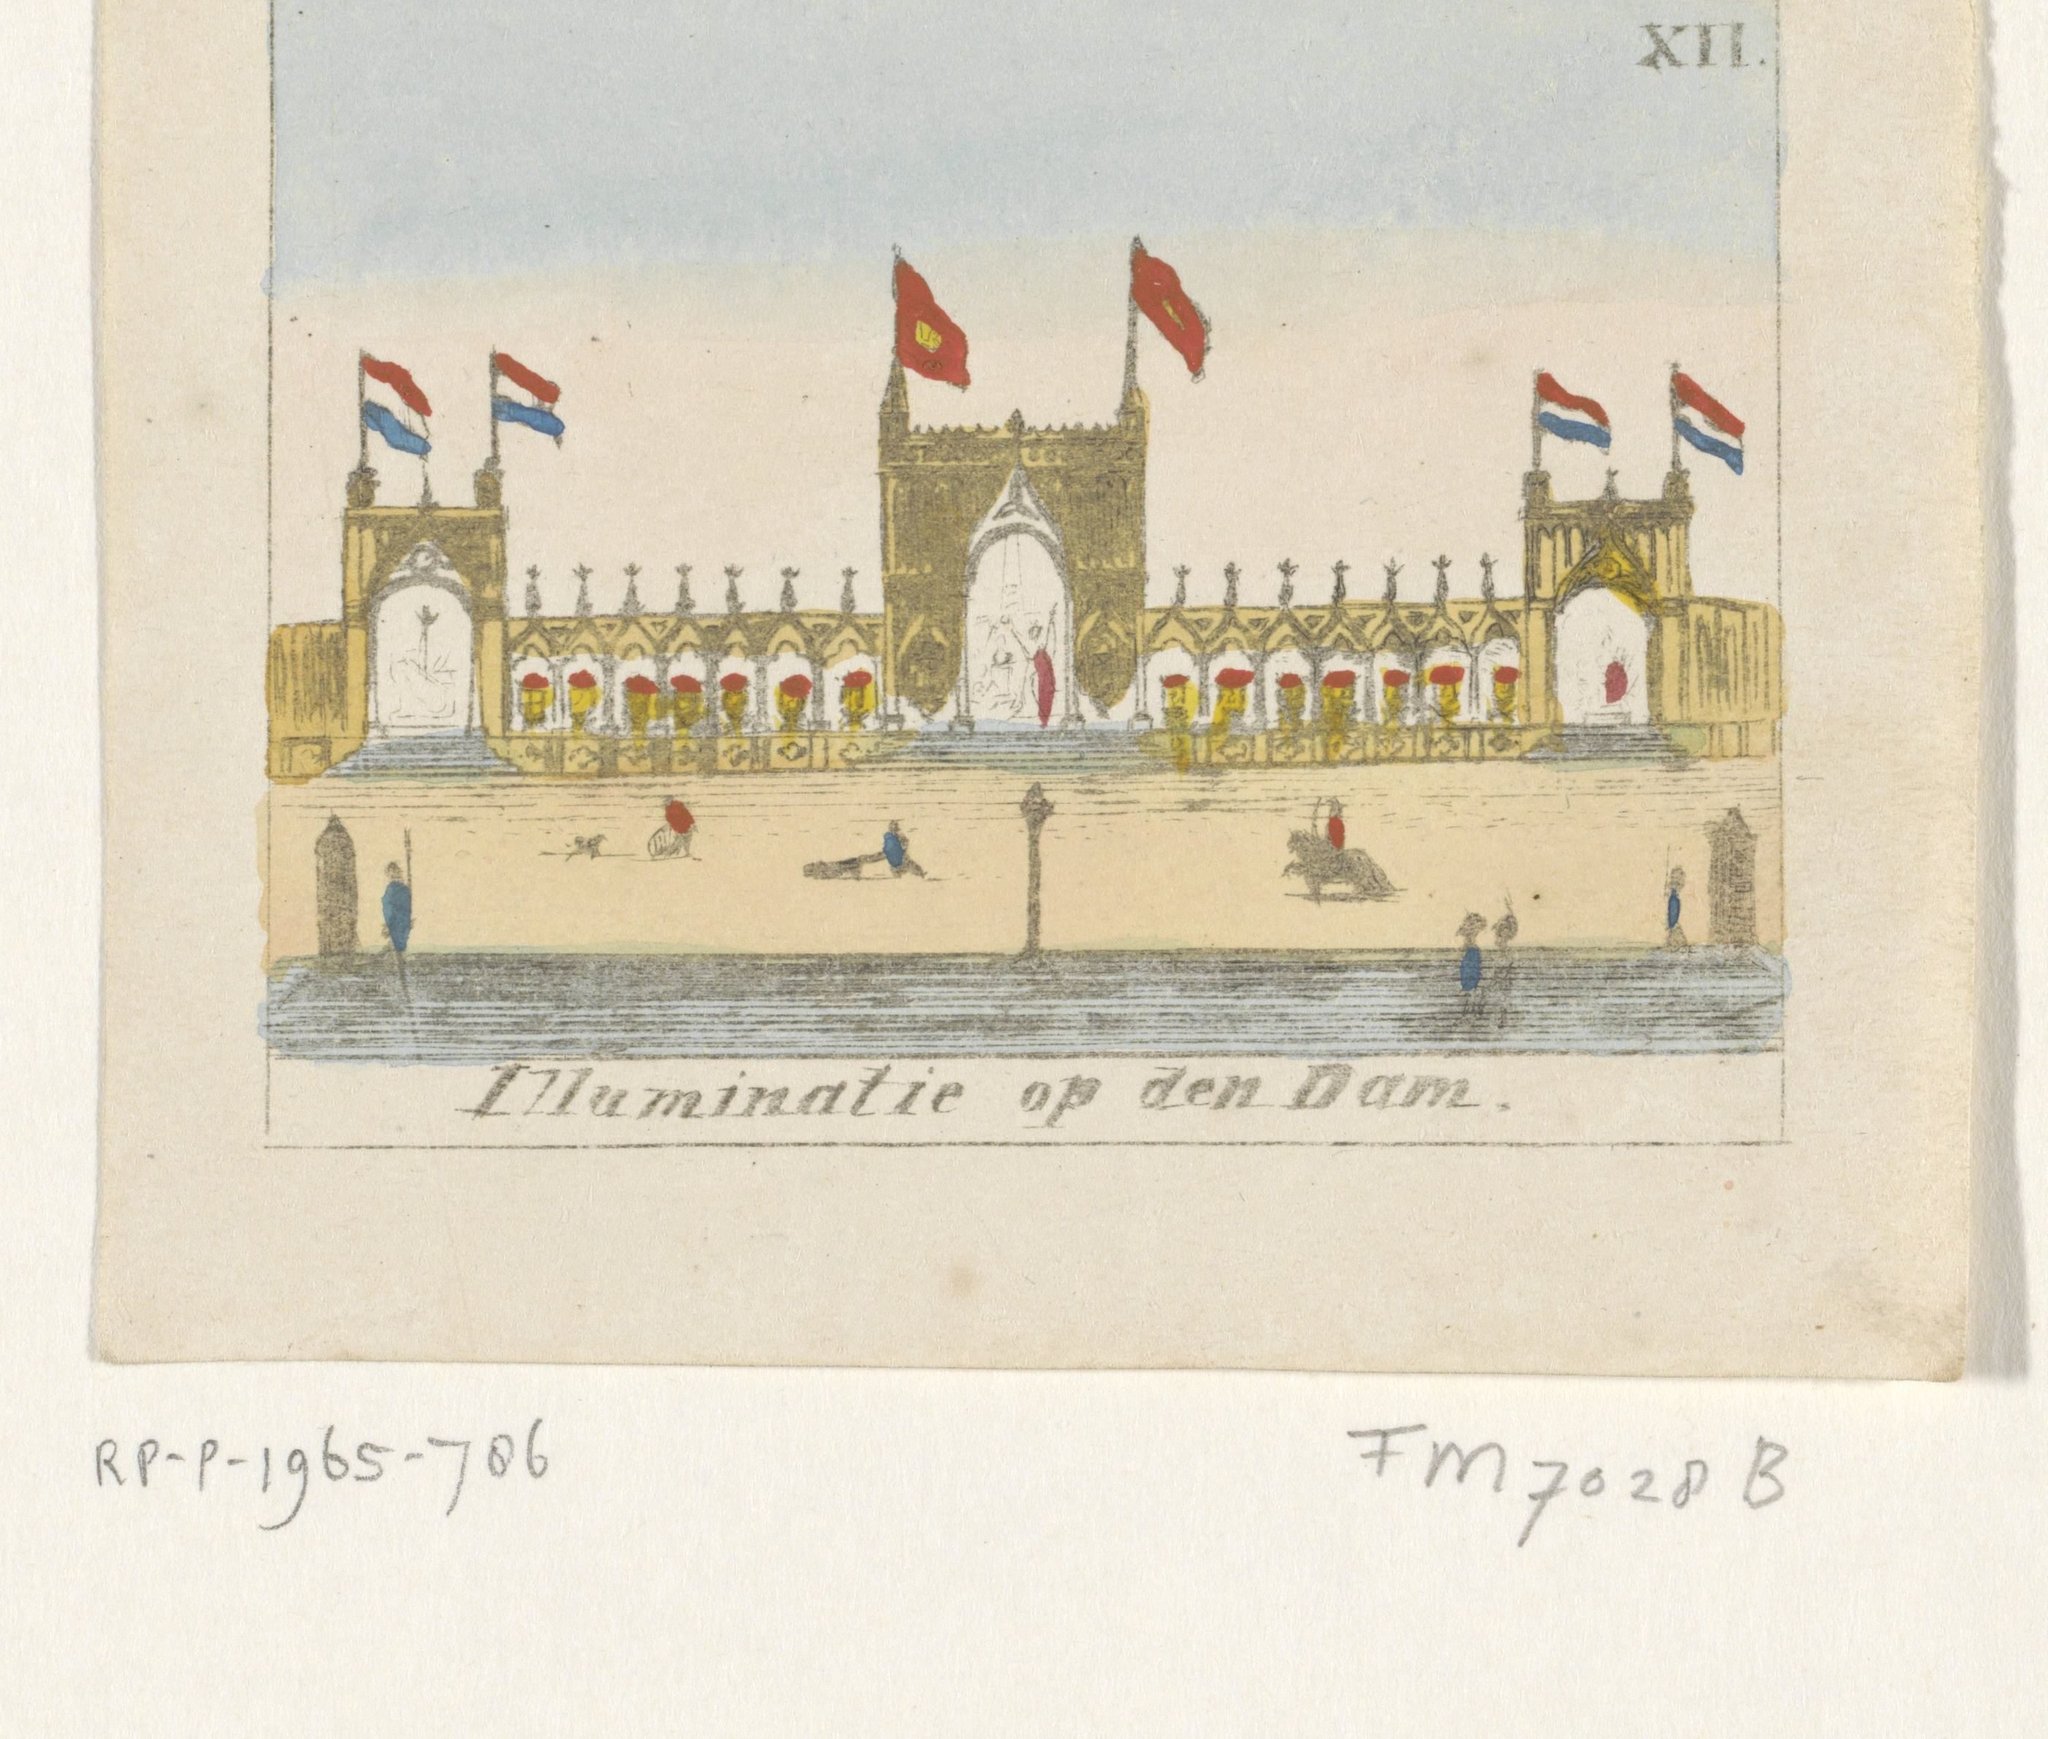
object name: print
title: Herinnerings Geschenkje aan 1840, voor de Nederlandsche Jeugd, ter gedachtenis aan de Plegtige Inhuldiging van Z.M. Koning Willem II. Met XII plaatjes waarop het merkwaardigste is voorgesteld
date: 1840-1841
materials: paper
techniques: hand coloring, lithograph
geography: amsterdam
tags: the hague, william ii of the netherlands, triumphal entry and public reception, pageant, 'entrée solennelle', 'joyeuse entrée' (+ illumination, fire-works ~ festive activities), other forms of installation, amsterdam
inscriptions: collector's mark: Lugt 2228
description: Illuminatie van een stellage op de Dam. Onderdeel van mapje met een serie van twaalf prentjes van de intocht van Willem II, de erepoorten opgericht in de stad en de inhuldiging op 28 november 1840 in de Nieuwe Kerk te Amsterdam.